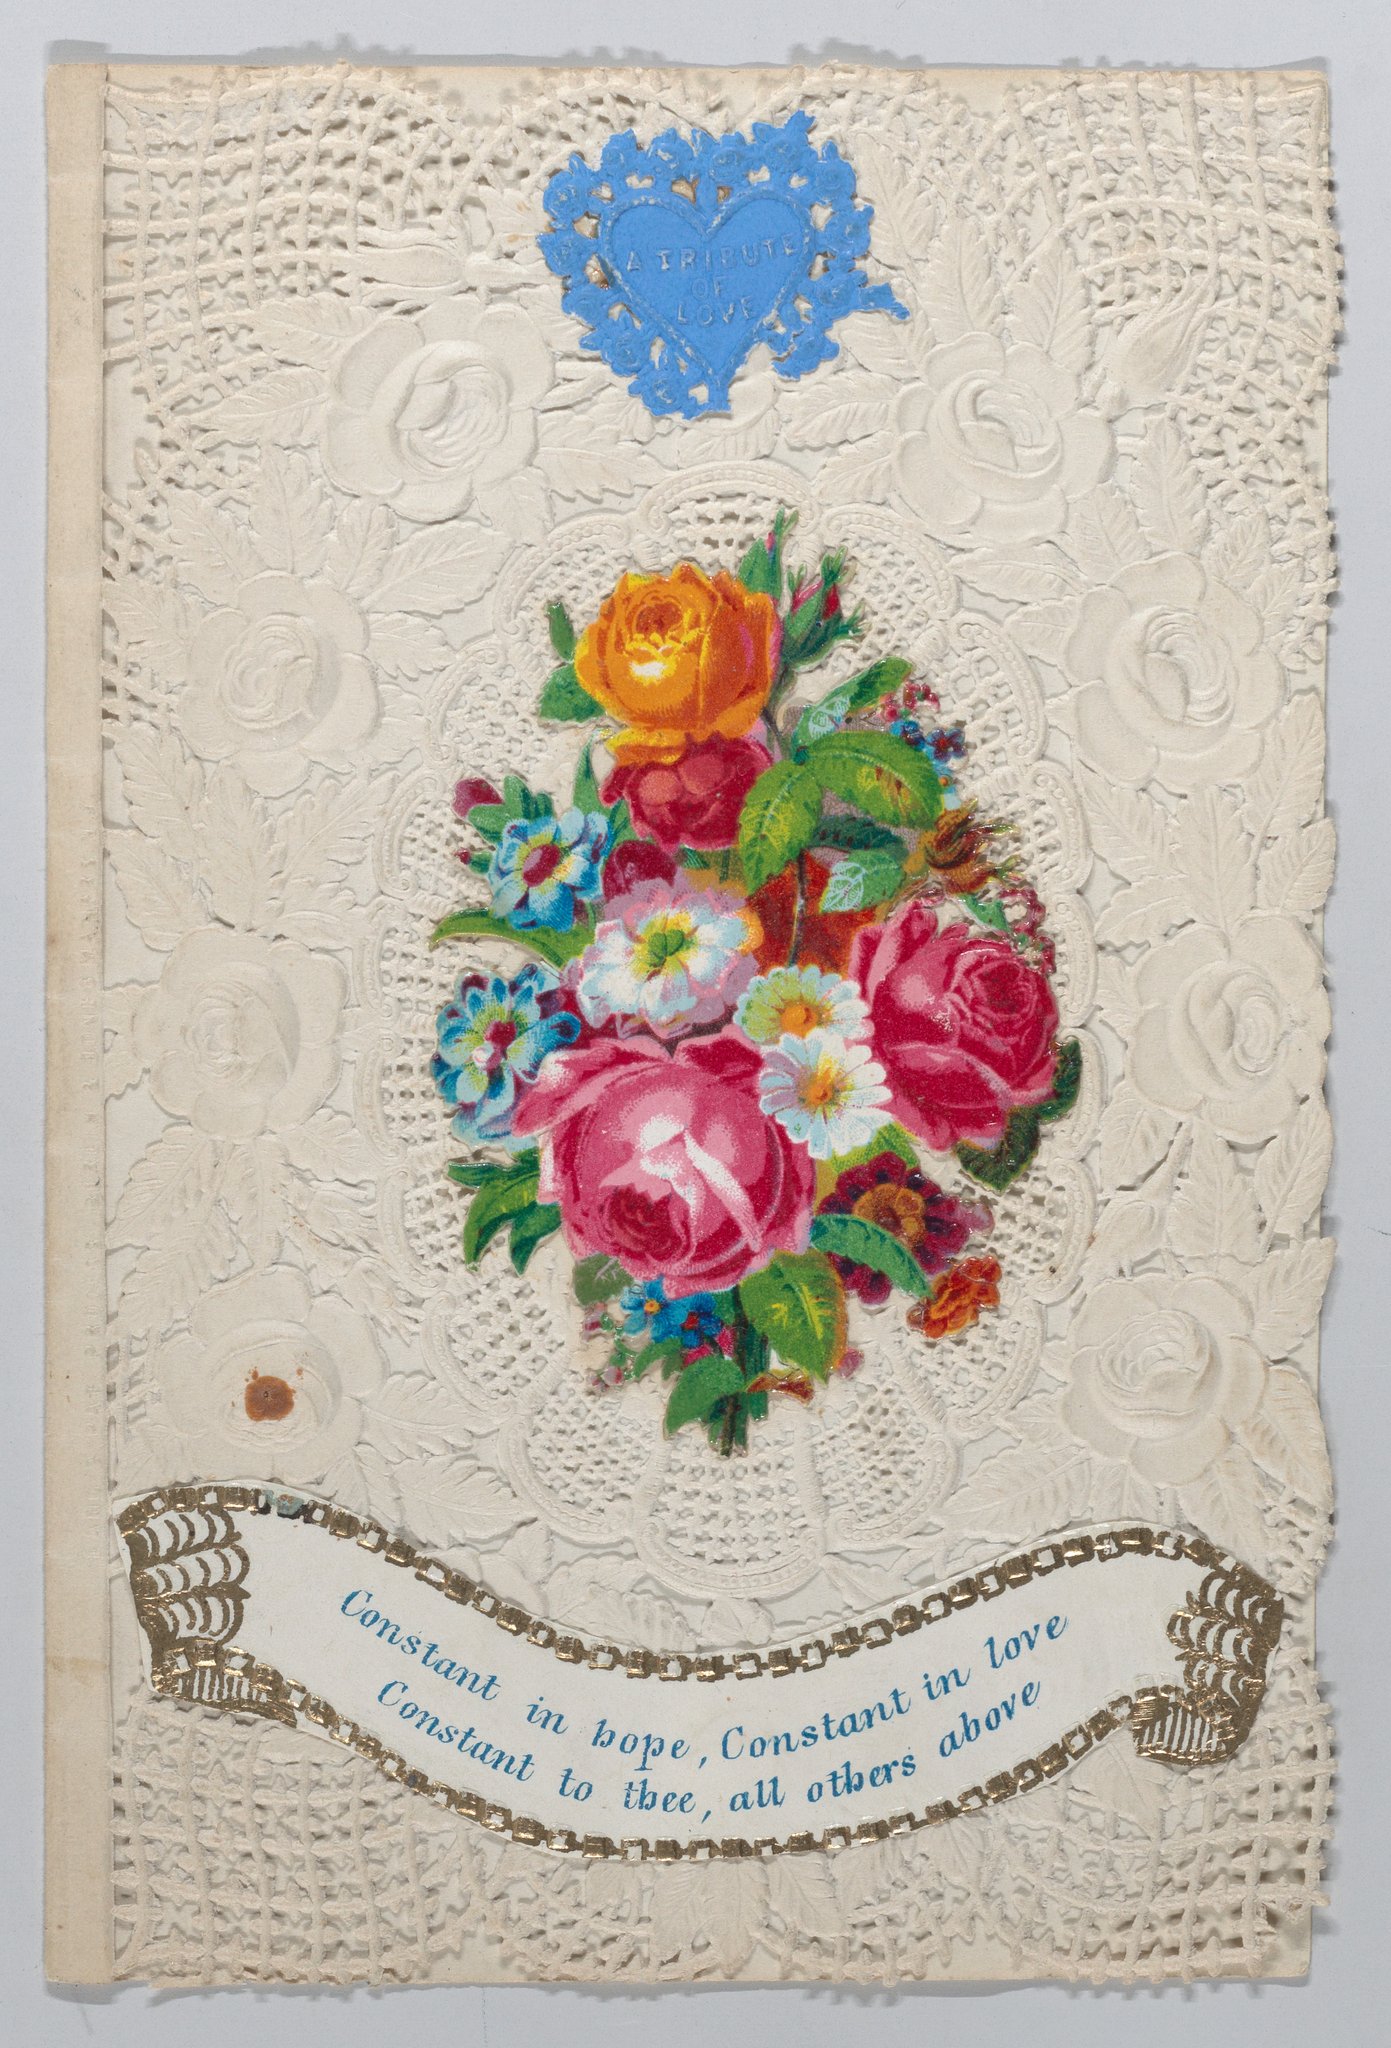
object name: valentine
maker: Anonymous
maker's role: artist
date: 1850-1879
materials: lace, paper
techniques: chromolithography, cutting, embossing, open work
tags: flowers